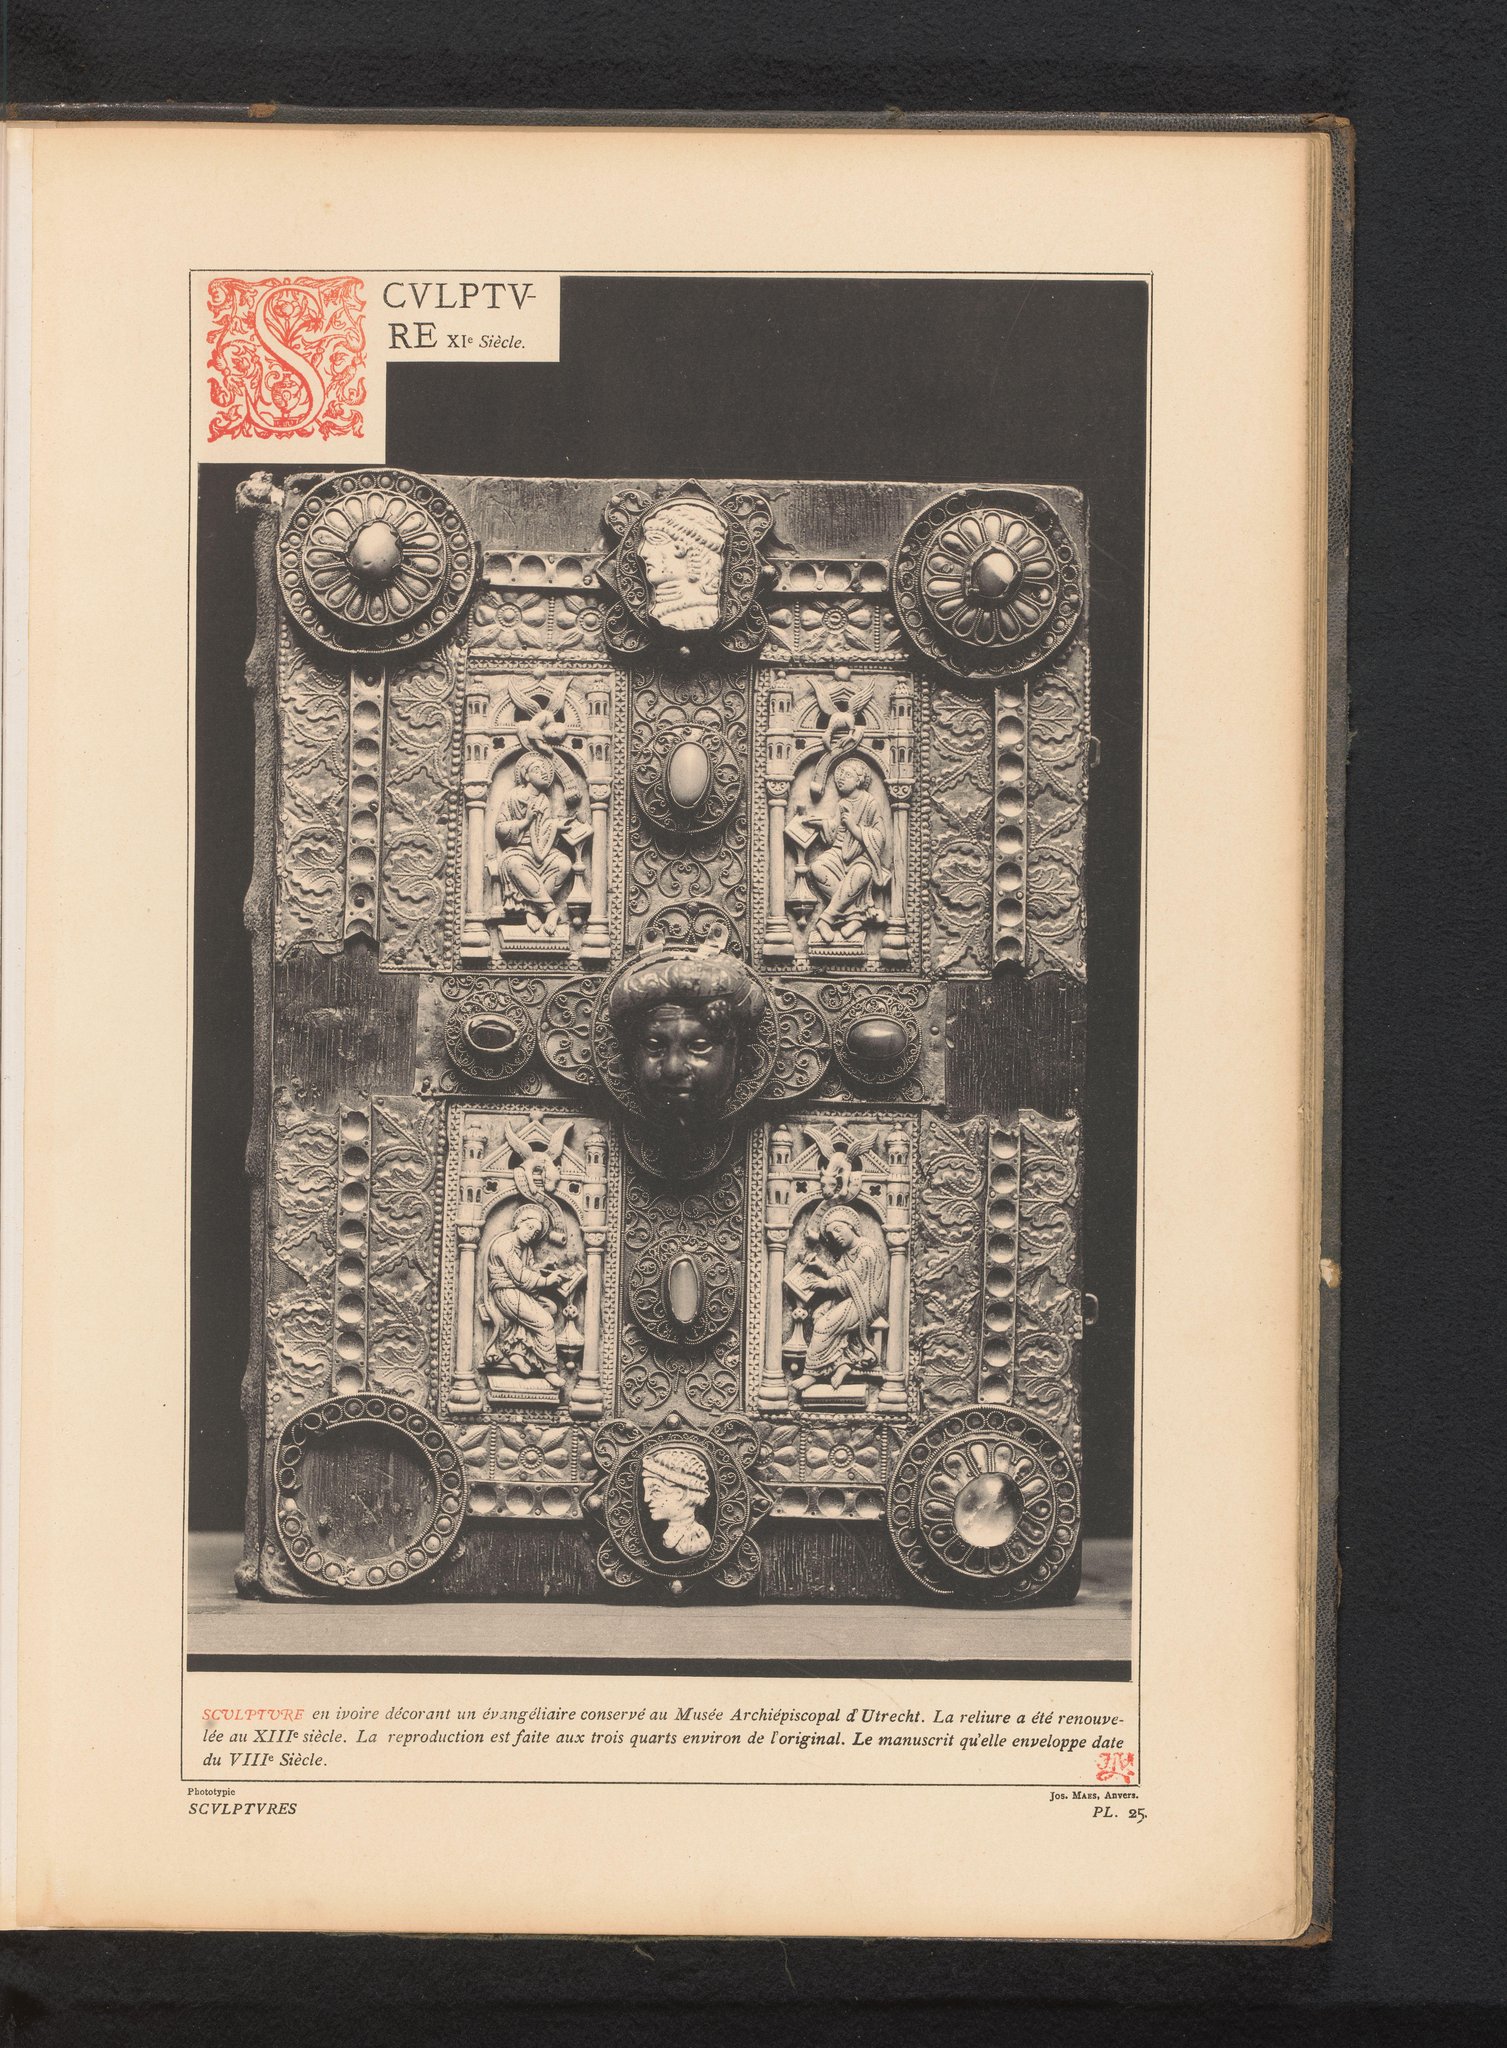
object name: photomechanical print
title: Evangeliarium met ivoren decoratie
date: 1881-1889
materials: paper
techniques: photograph, photolithography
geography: antwerp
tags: sculpture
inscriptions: monogram: ‘JJvY’, inscription: ‘SCULPTURE en ivoire (...)’, inscription: ‘SCULPTURES. PL. 25.’